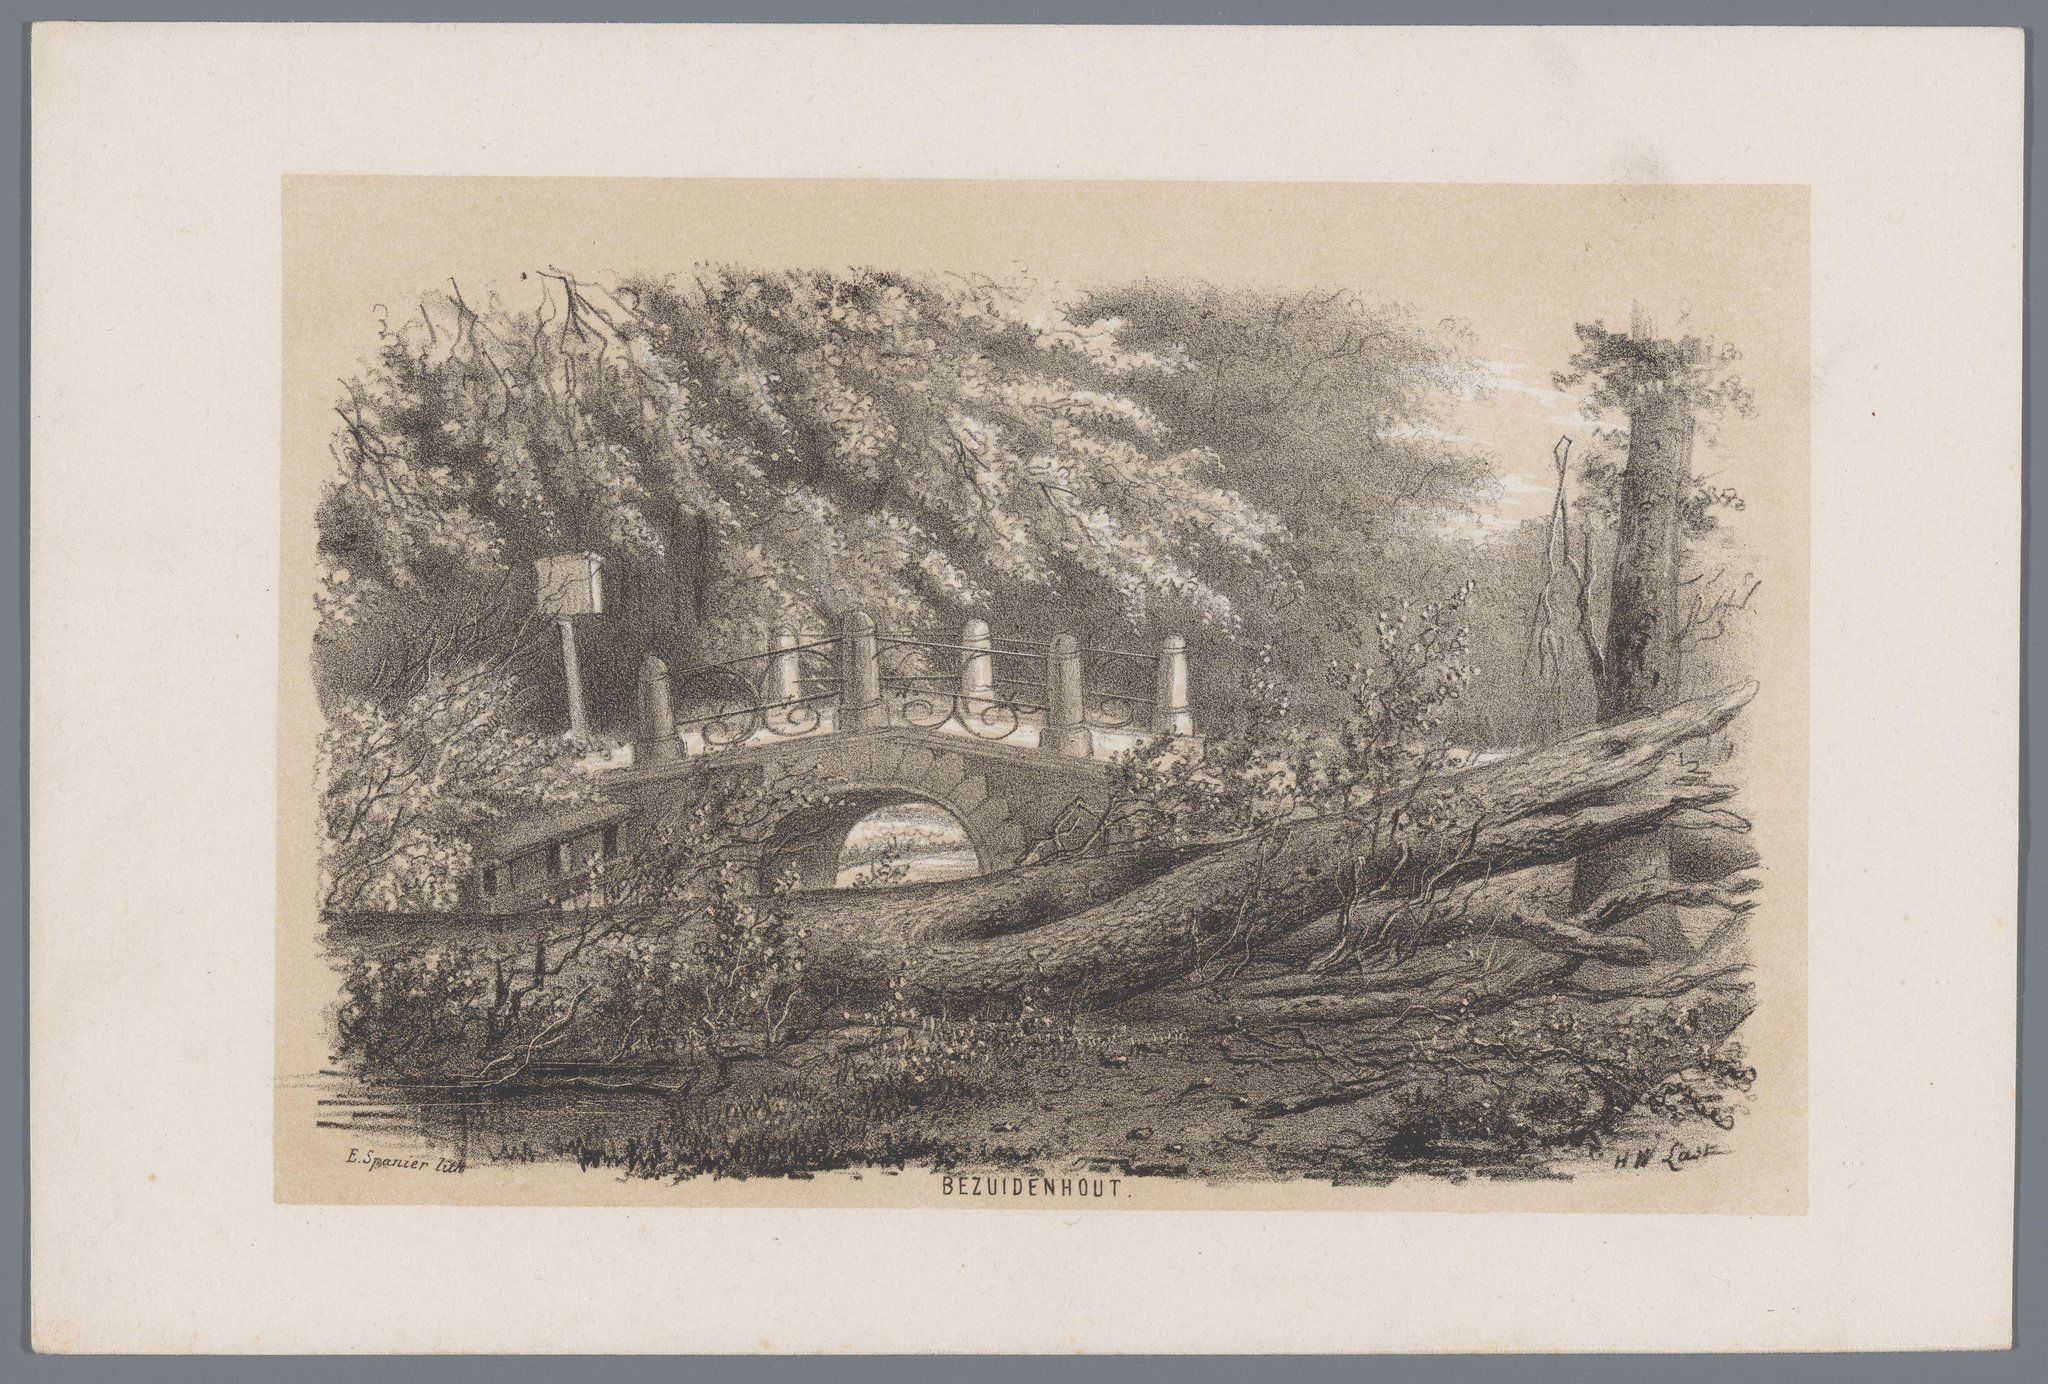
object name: print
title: Omgewaaide boom in Bezuidenhout, na de storm van 28 mei 1860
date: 1860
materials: paper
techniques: tone lithography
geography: the hague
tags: storm on land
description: Een omgewaaide boom bij een brug in Bezuidenhout, na de storm. Onderdeel van het album met tien losse steendrukken in een papieren omslag met voorstellingen van de schade aangericht door de 'Pinksterstorm' van 28 mei 1860 in het Haagse Bos en omgeving.